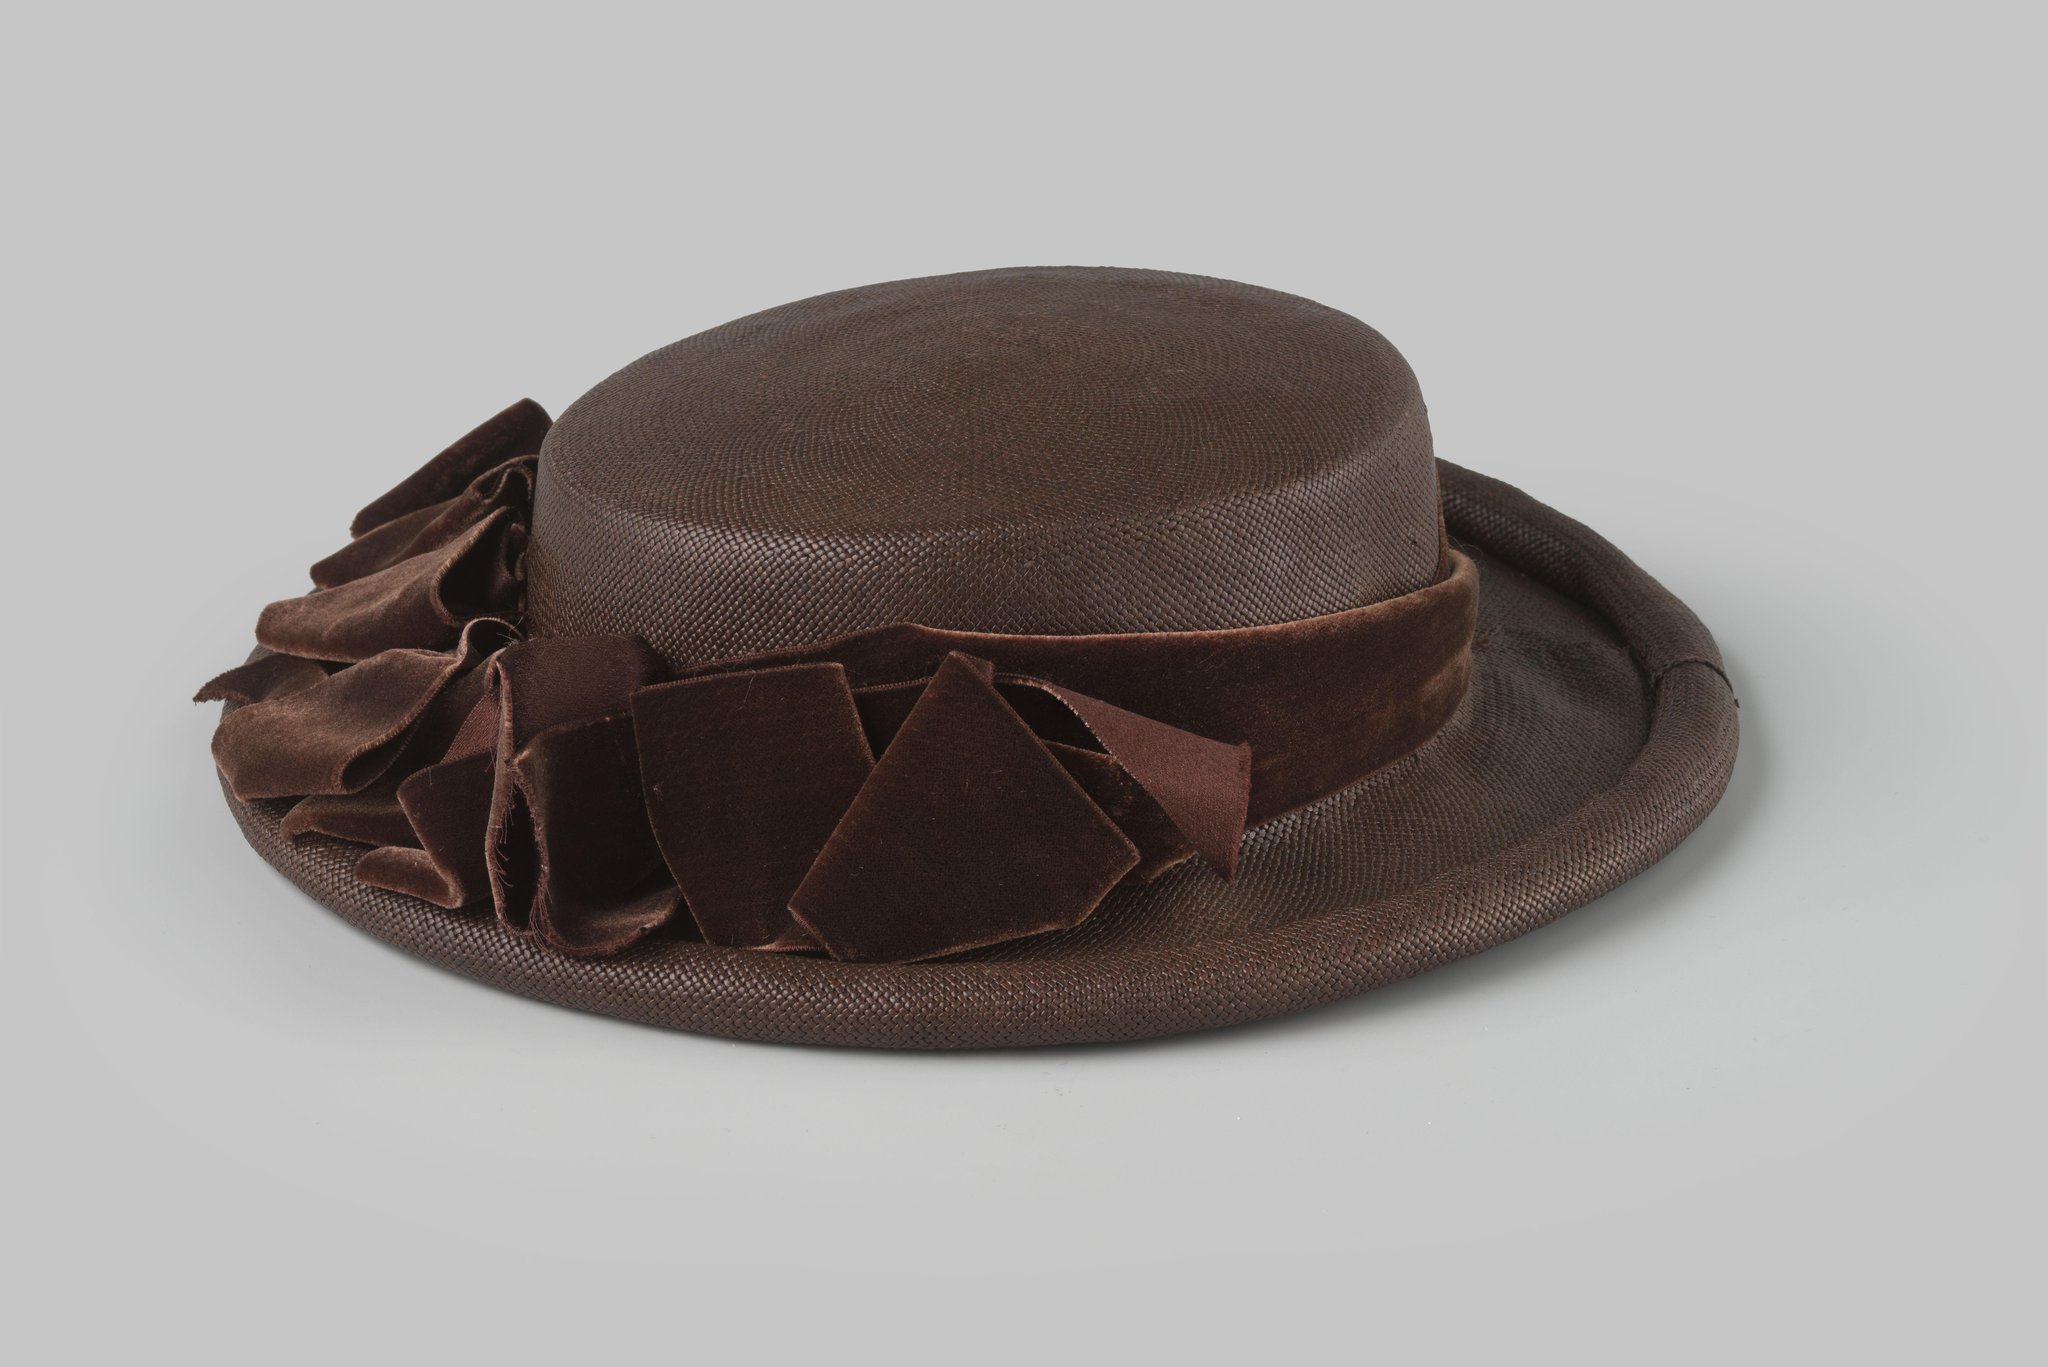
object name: zomerhoed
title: Hoed van bruin stro, met bruine bandfluwelen strikken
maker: de prijslijst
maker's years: 1886-1959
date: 1948-1955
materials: ribbon, straw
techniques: fluweelband, strohalm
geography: amsterdam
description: Zomerhoed van bruin stro, met bruin bandfluweel. 'Matelot' model, 'straw-boater', met omgekrulde buitenrand, platte bodem, vlakke, rondom gelijke rand. Breed, bruin bandfluweel is om de bol gelegd, van voren op de halve rand met acht lussen. Adres: De Prijslijst/AMSTERDAM/53 P.C. HOOFTSTRAAT.